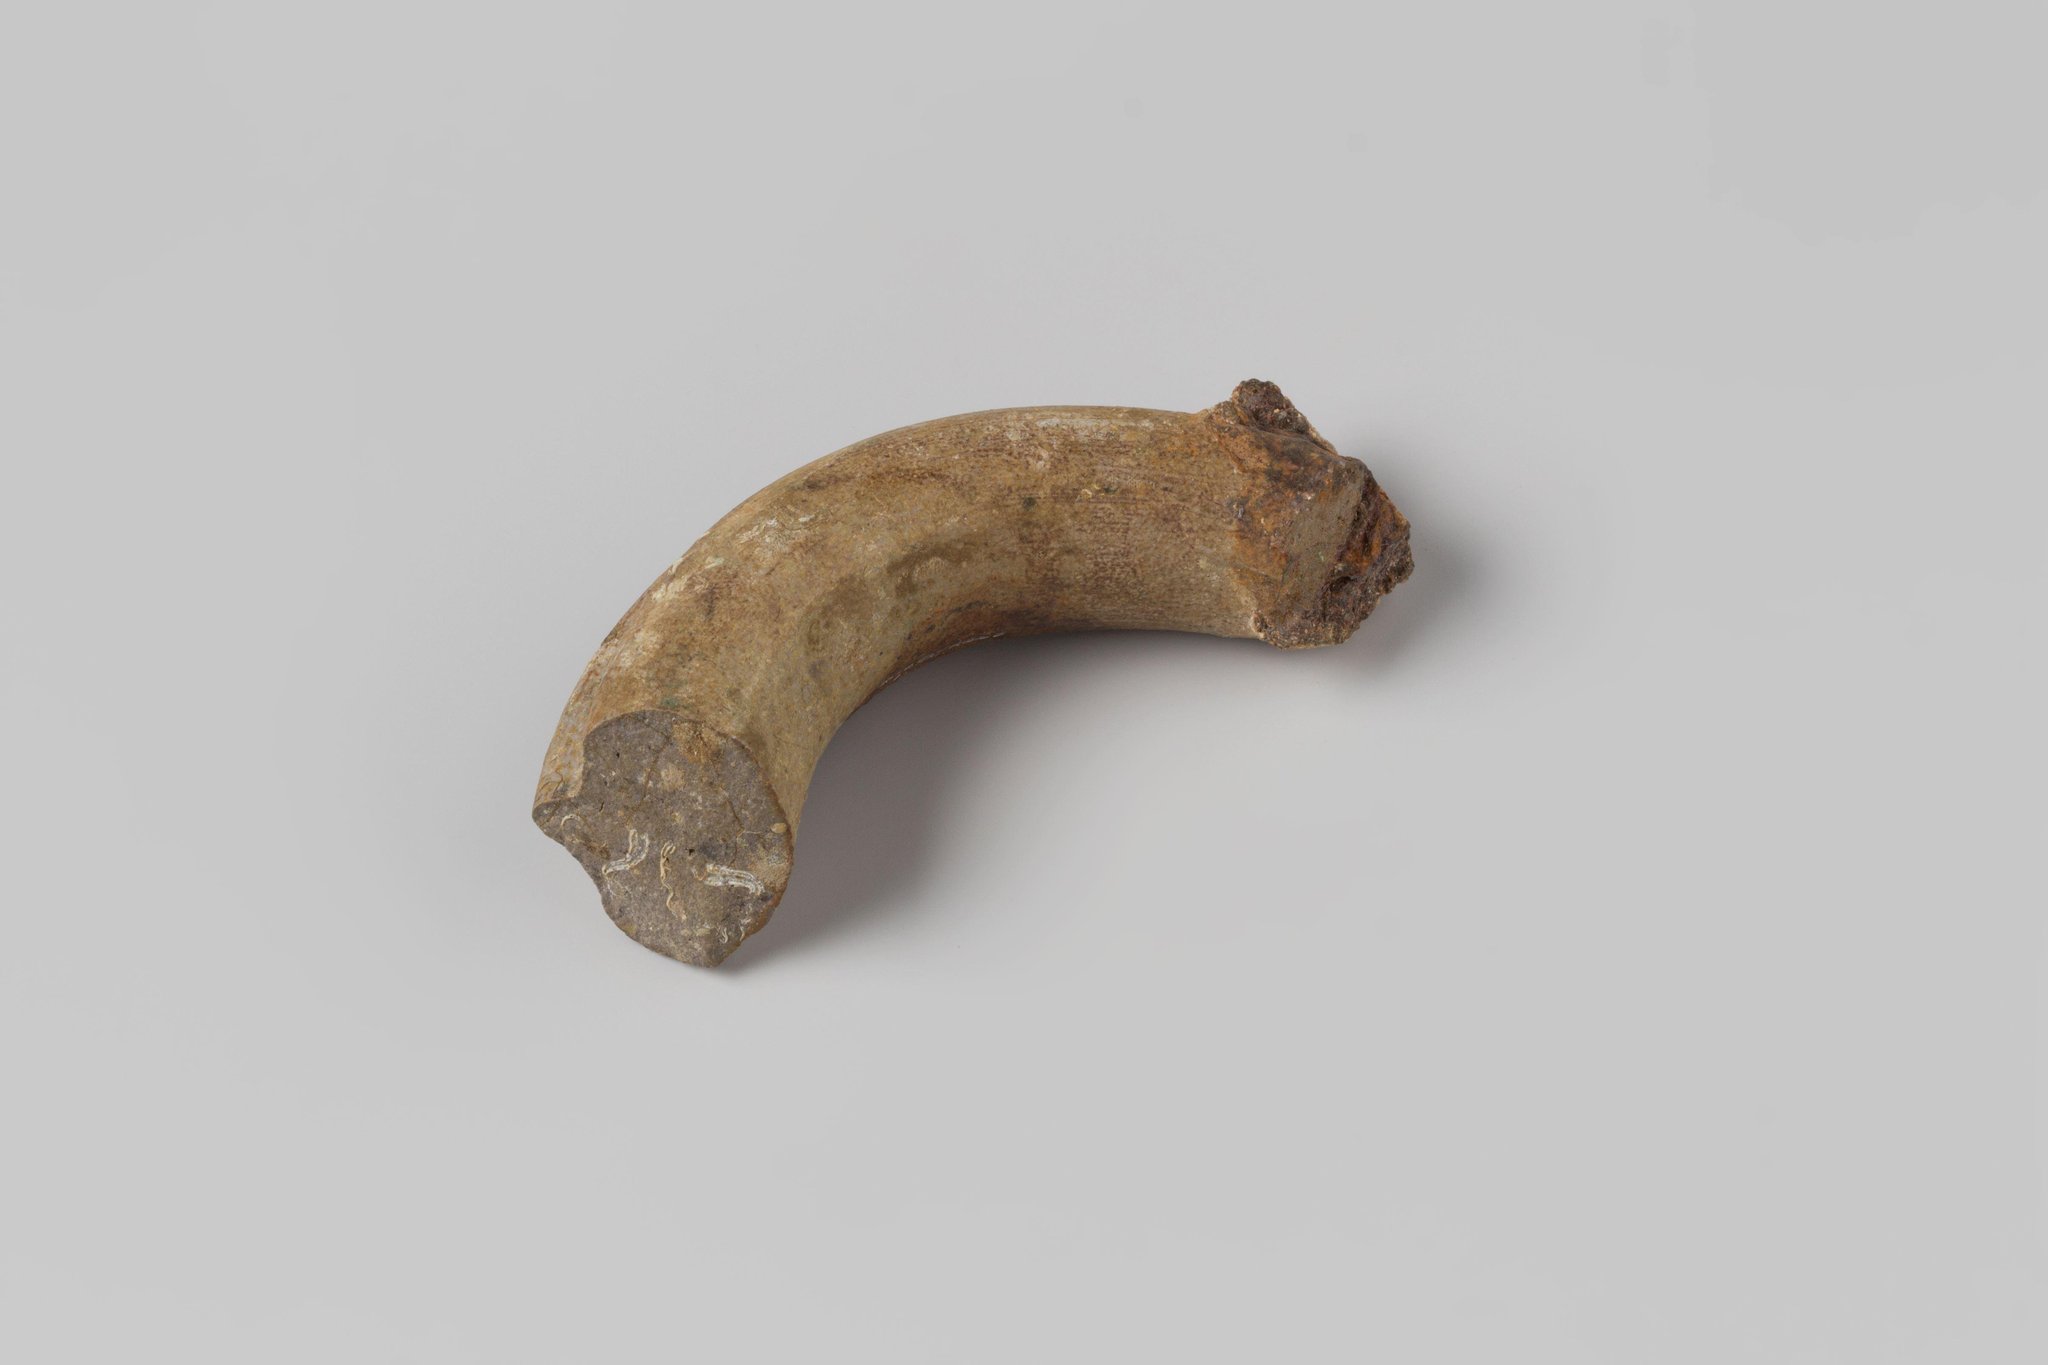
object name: ewer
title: Oor van een kan uit het wrak van de Oost-Indiëvaarder Hollandia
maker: Anonymous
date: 1700-1743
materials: stoneware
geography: cologne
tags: verenigde oostindische compagnie, hollandia (schip), annet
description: Stoneware, Rhenish, Frechen-ware, jug; fragm of handle, with a raised rib along centre.